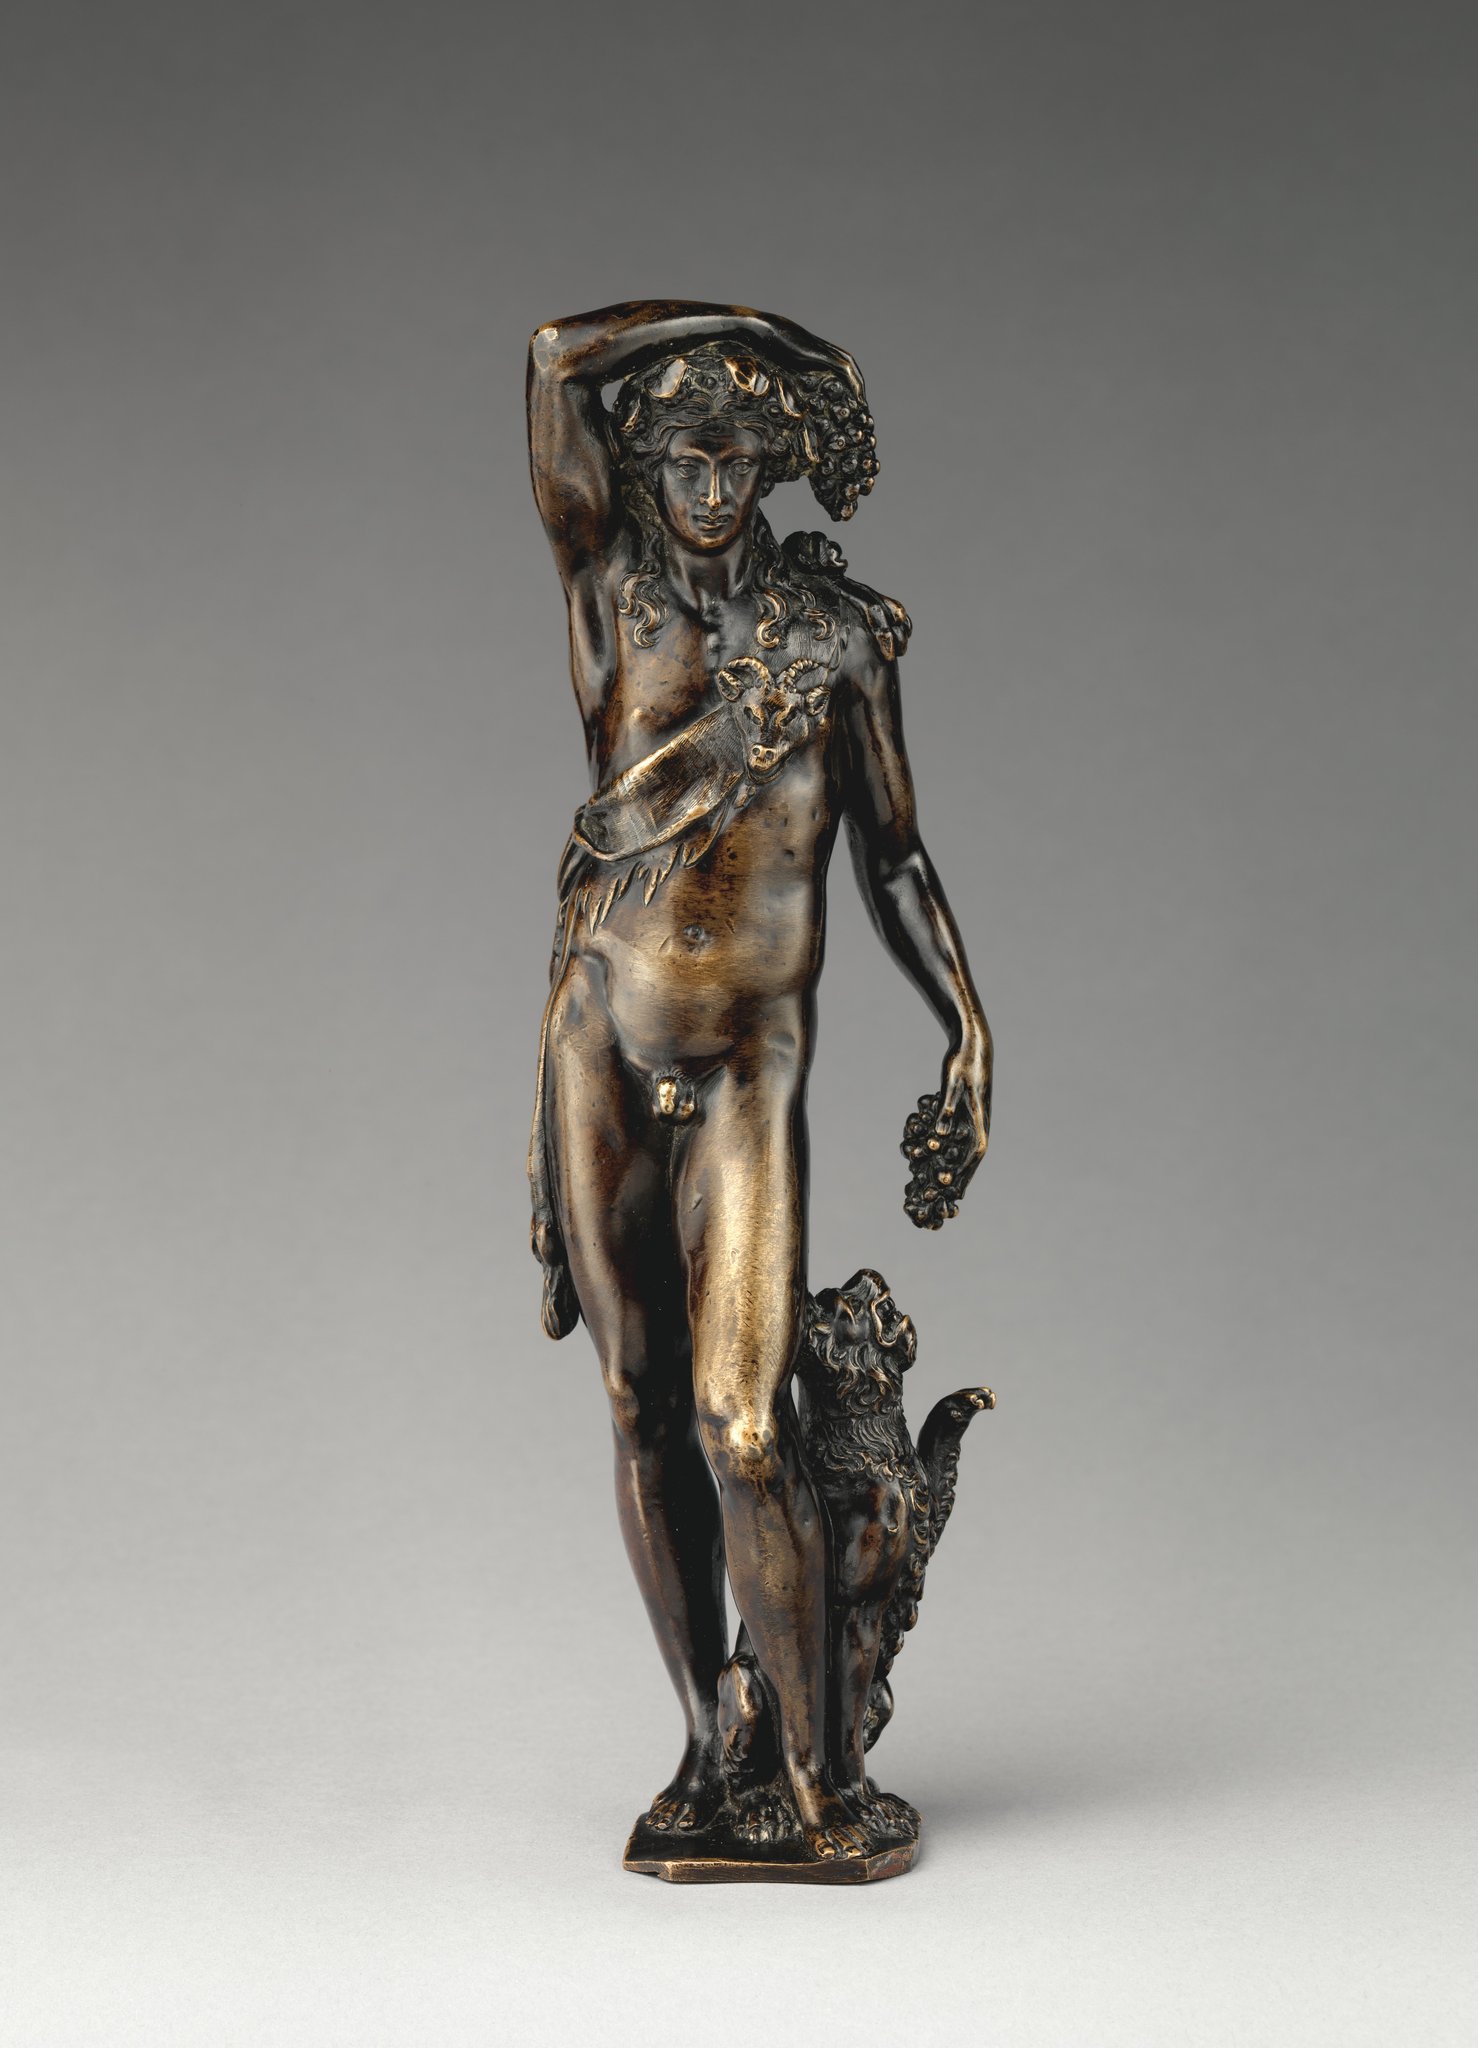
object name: statuette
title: Bacchus and a Panther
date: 1501-1700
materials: bronze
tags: animals,grapes,bacchus